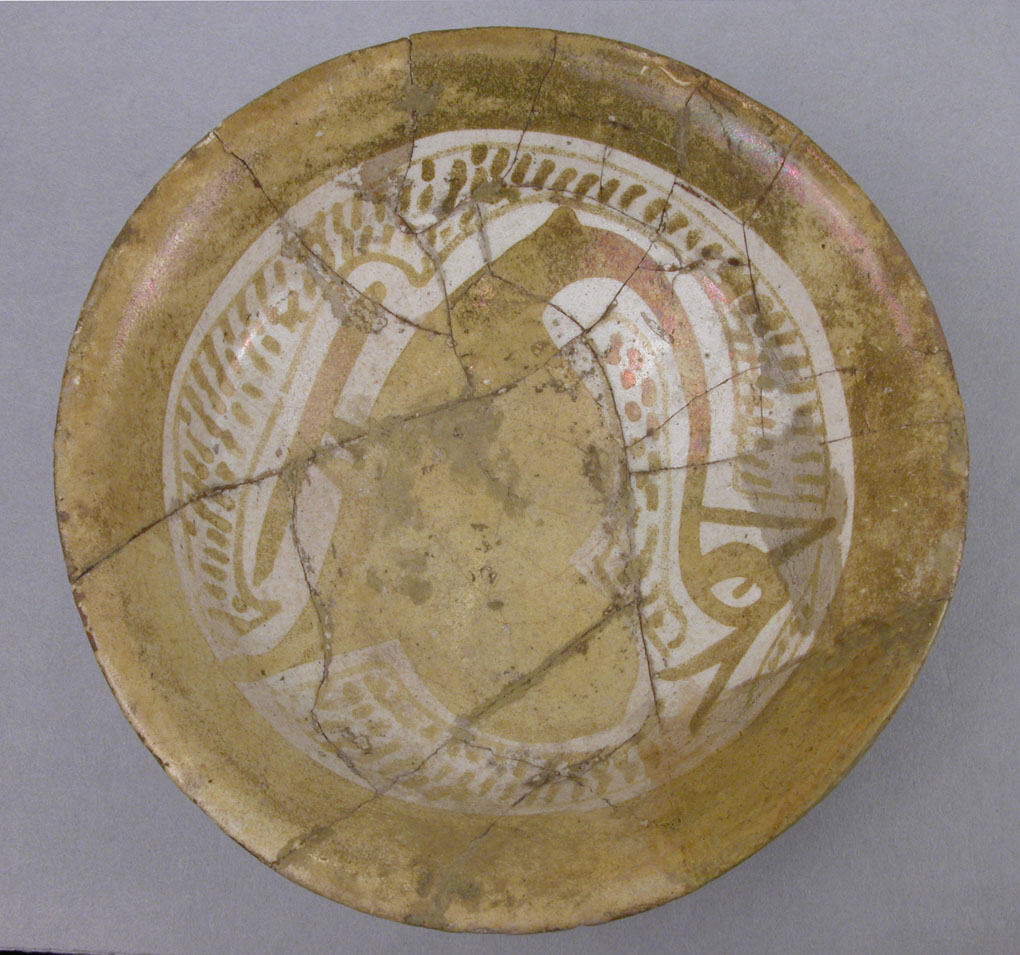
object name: bowl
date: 901-1000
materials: earthenware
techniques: glazing, luster painting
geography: iraq